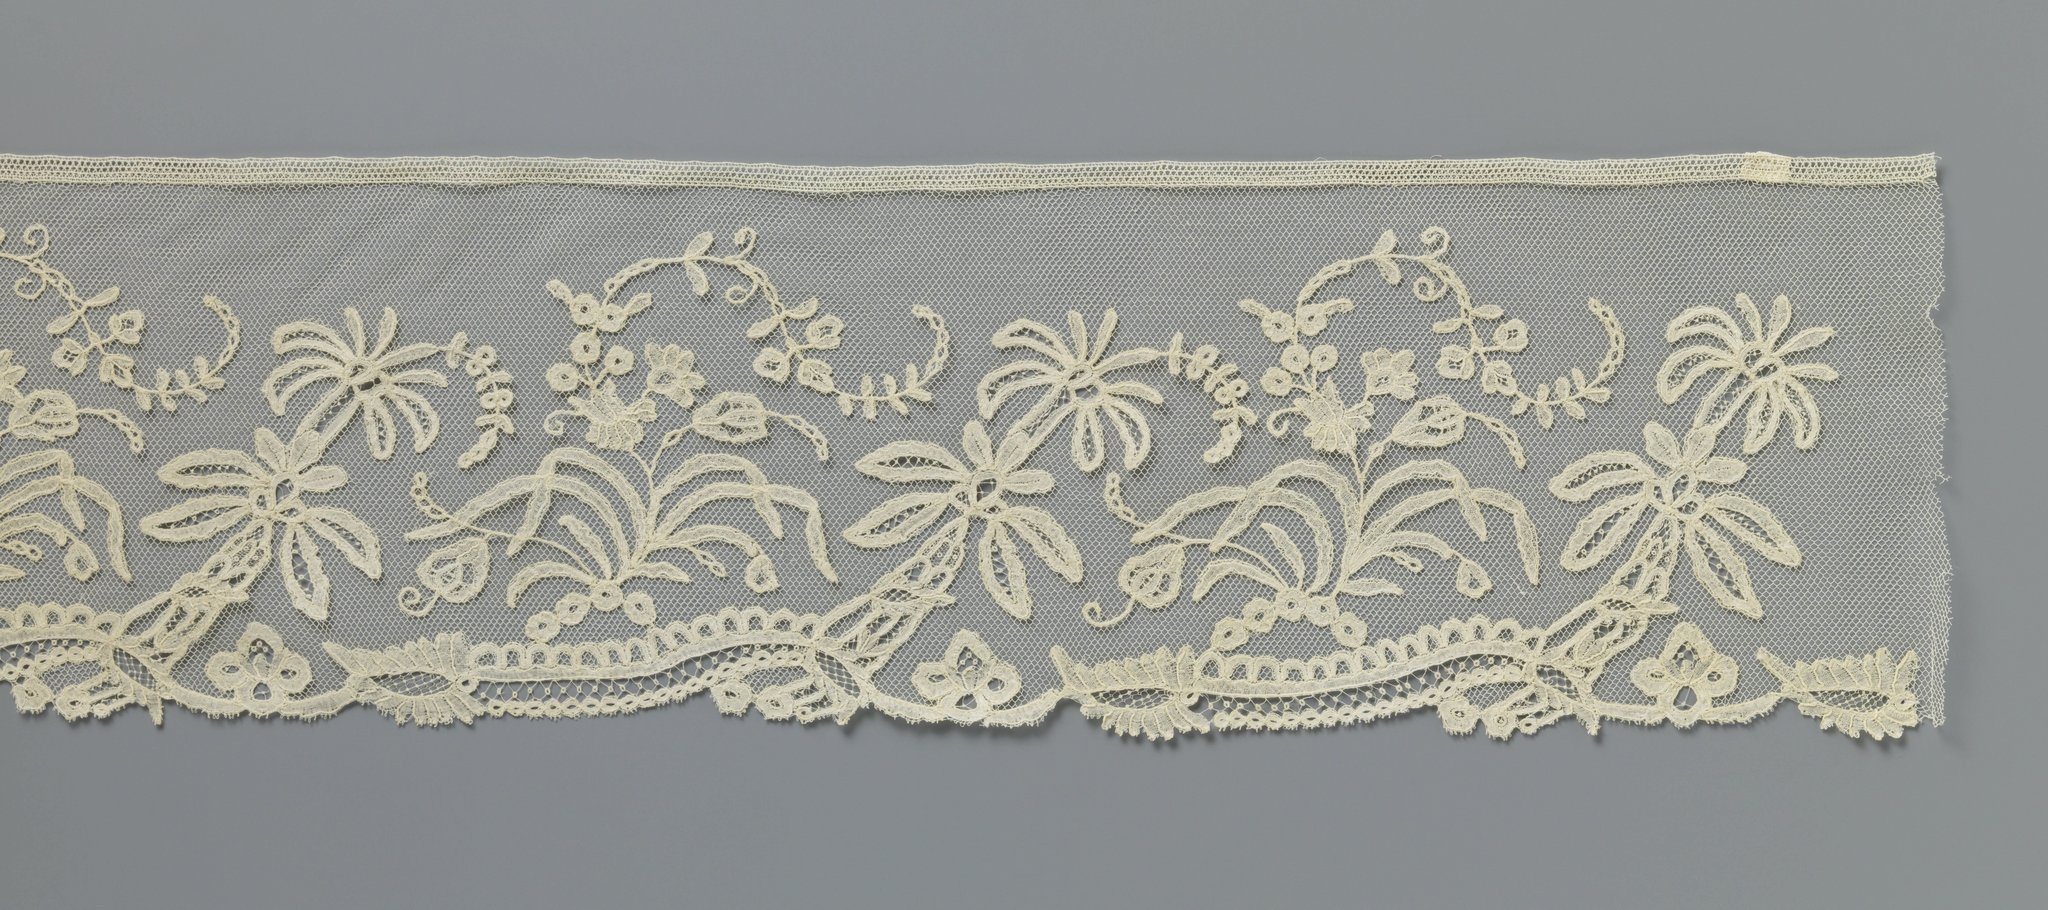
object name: strip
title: Japonstrook applicatiekant met palmboom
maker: Anonymous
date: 1840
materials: linen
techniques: lace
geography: brussels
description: Japonstrook van naturelkleurige applicatiekant, kloskant met enige details in naaldkant geappliceerd op machinale tule. Het fond is gelijkmatig gevuld met een lopend patroon van palmbomen, die naar links overhellen en met een stam en een waaiervormige kruin beginnen, om vervolgens te splitsen in verscheidene stammen en kleinere kruinen. Uit de laatste ontspringen veelsoortige, onder andere met pijlvormige bladeren versierde takken, die links en rechts diep neerhangen, terwijl hier en daar in hun voluten slingers zijn gehangen. Tussen twee stammen groeit telkens een lage bloeiende plant, die met een fijne bladrozet begint. De schulpen worden gevormd door slingerende kantstroken en gevederde bladeren.